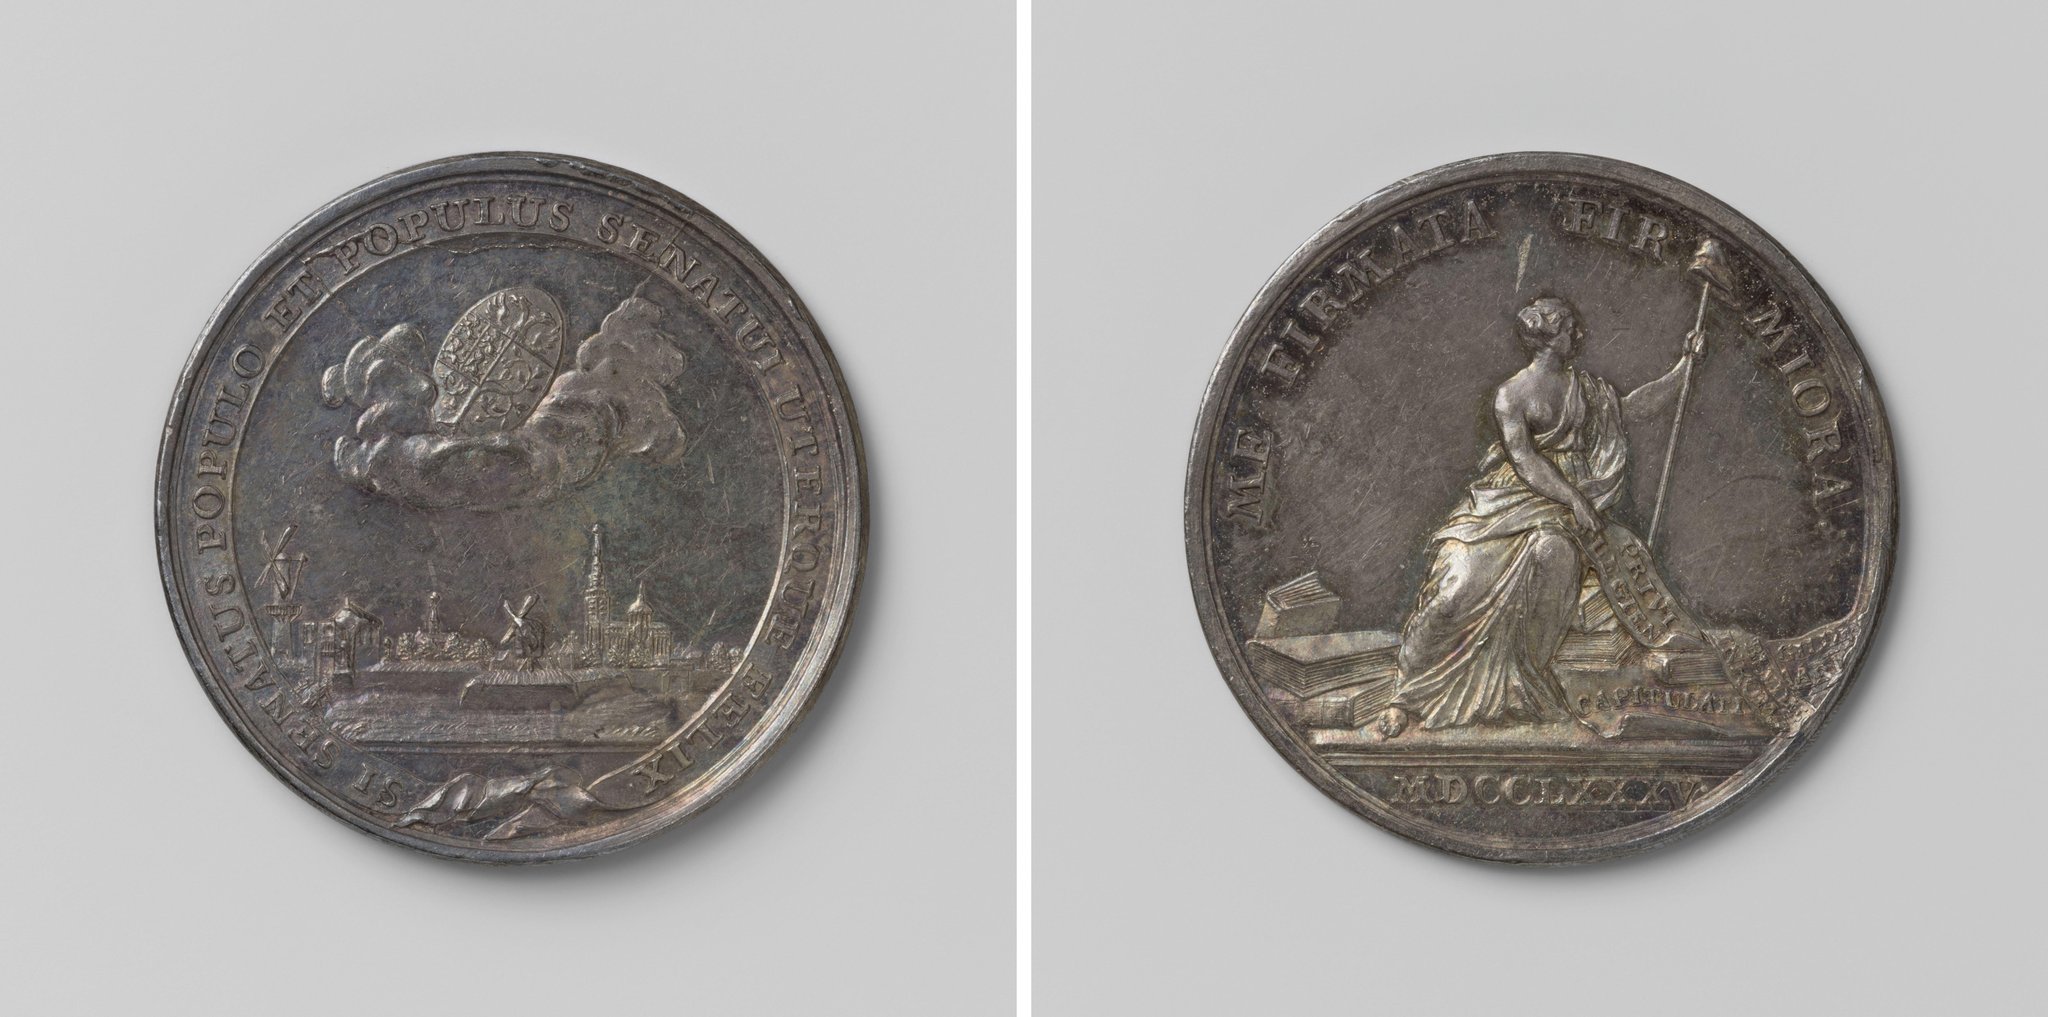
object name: council medal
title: Vroedschapspenning van de stad 's-Hertogenbosch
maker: theodorus victor van berckel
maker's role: mintmaster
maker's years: 1739-1808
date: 1785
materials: silver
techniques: striking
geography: den bosch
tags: den bosch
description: Zilveren penning. Voorzijde: gezicht op stad vanaf de zuidzijde onder wolken, waarop wapenschild rust binnen omschrift op lint. Keerzijde: zittende, naar rechts gewende vrouw met vrijheidshoed op speer, voorstellende stad 's-Hertogenbosch, wijst met rechterhand op stapel boeken en papieren aan haar voeten binnen omschrift; afsnede: jaartal.